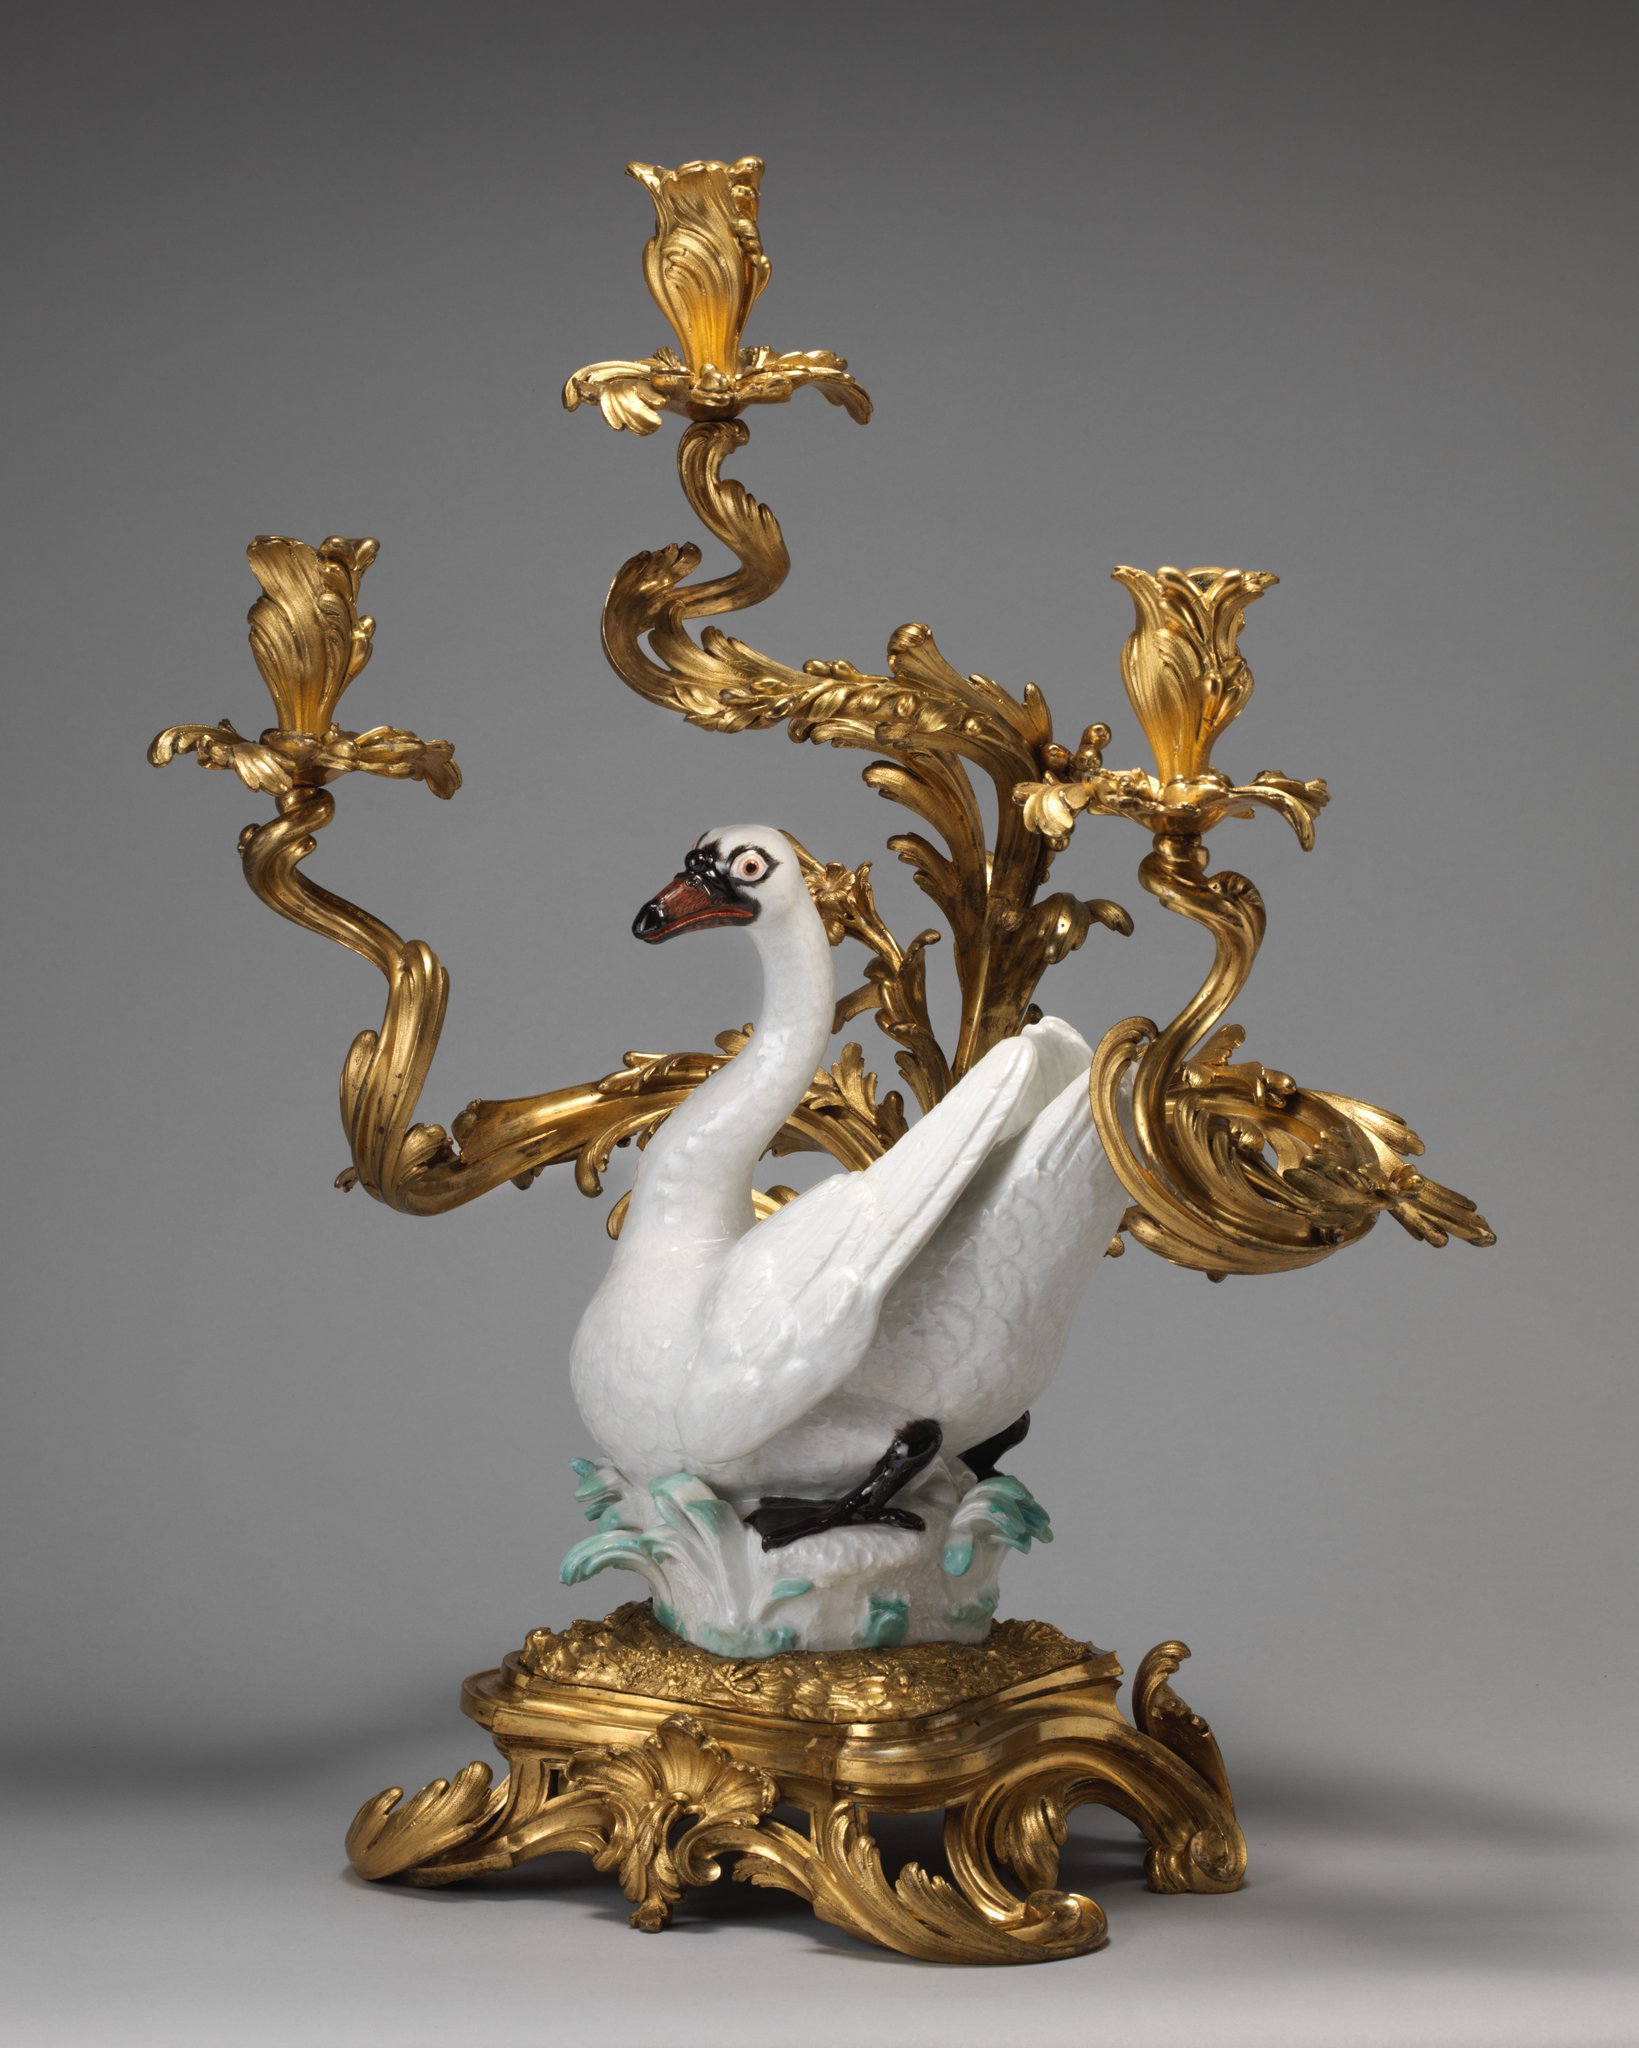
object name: candelabrum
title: Swan candelabrum (one of a pair)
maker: meissen manufactory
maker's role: manufactory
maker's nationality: german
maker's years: 1710-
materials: gilt bronze, hard paste porcelain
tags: swans